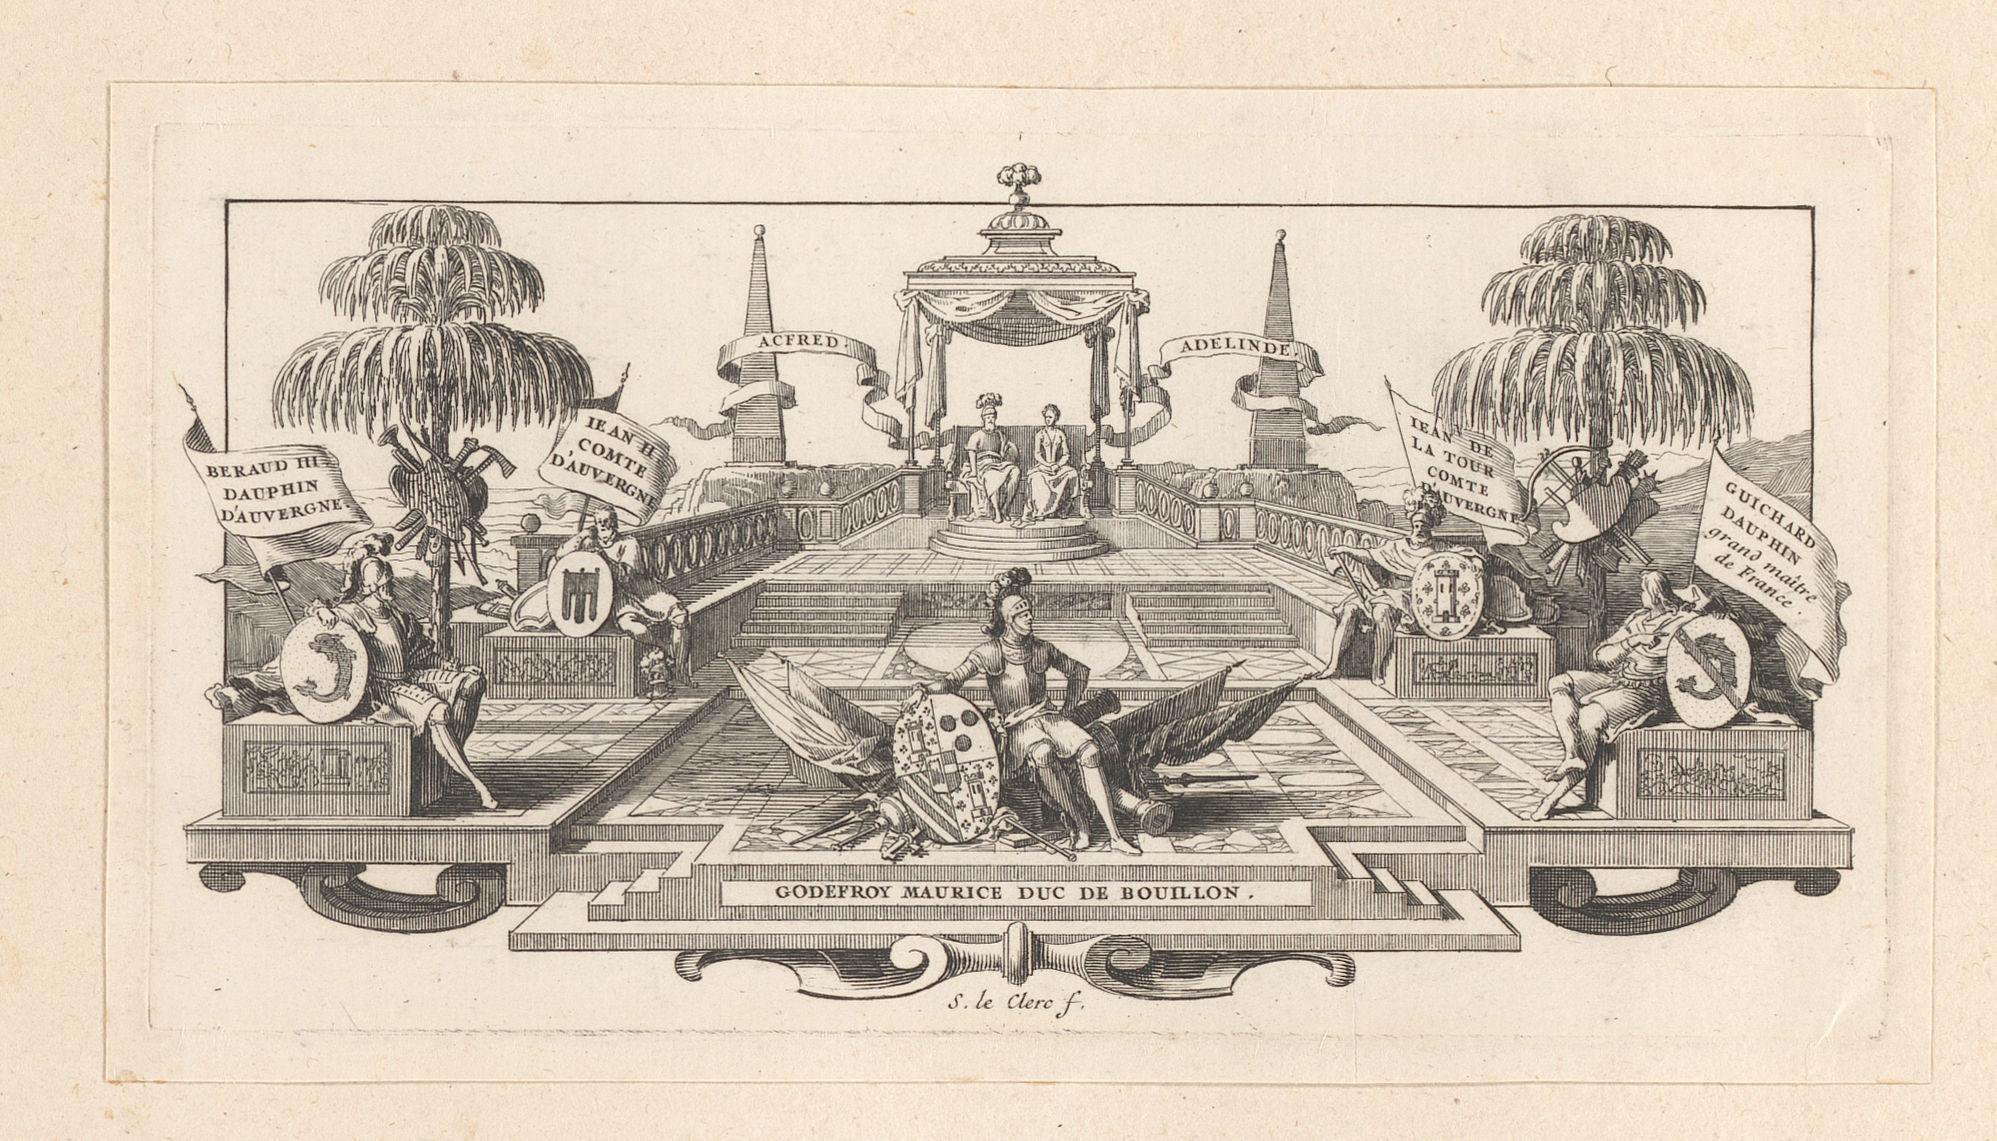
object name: album leaf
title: Vignet met de voorouders van de families d'Auvergne en de Bouillon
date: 1708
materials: paper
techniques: etching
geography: paris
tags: vignette, armorial bearing, heraldry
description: Prent uit: Baluze, Etienne. Histoire généalogique de la maison d'Auvergne, justifiée par chartres, titres, histoires anciennes et autres preuves authentiques. Parijs: Antoine Dezallier, 1708.